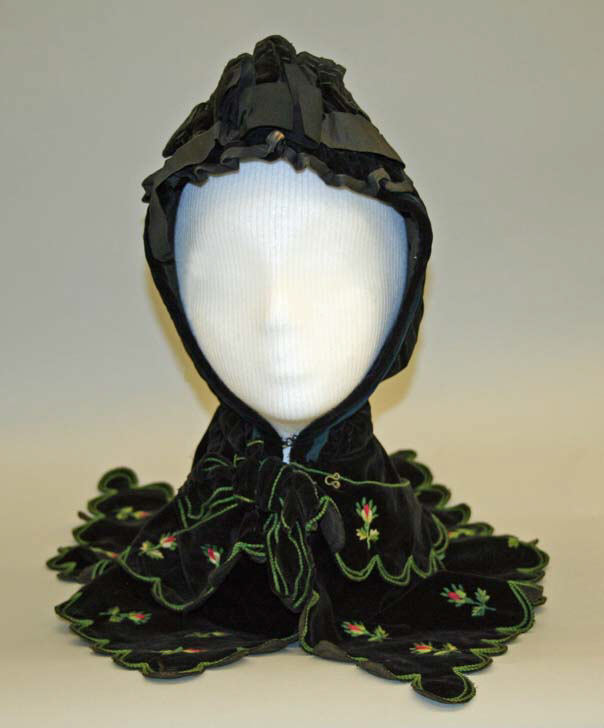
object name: hood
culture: european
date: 1863-1869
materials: silk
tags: flowers